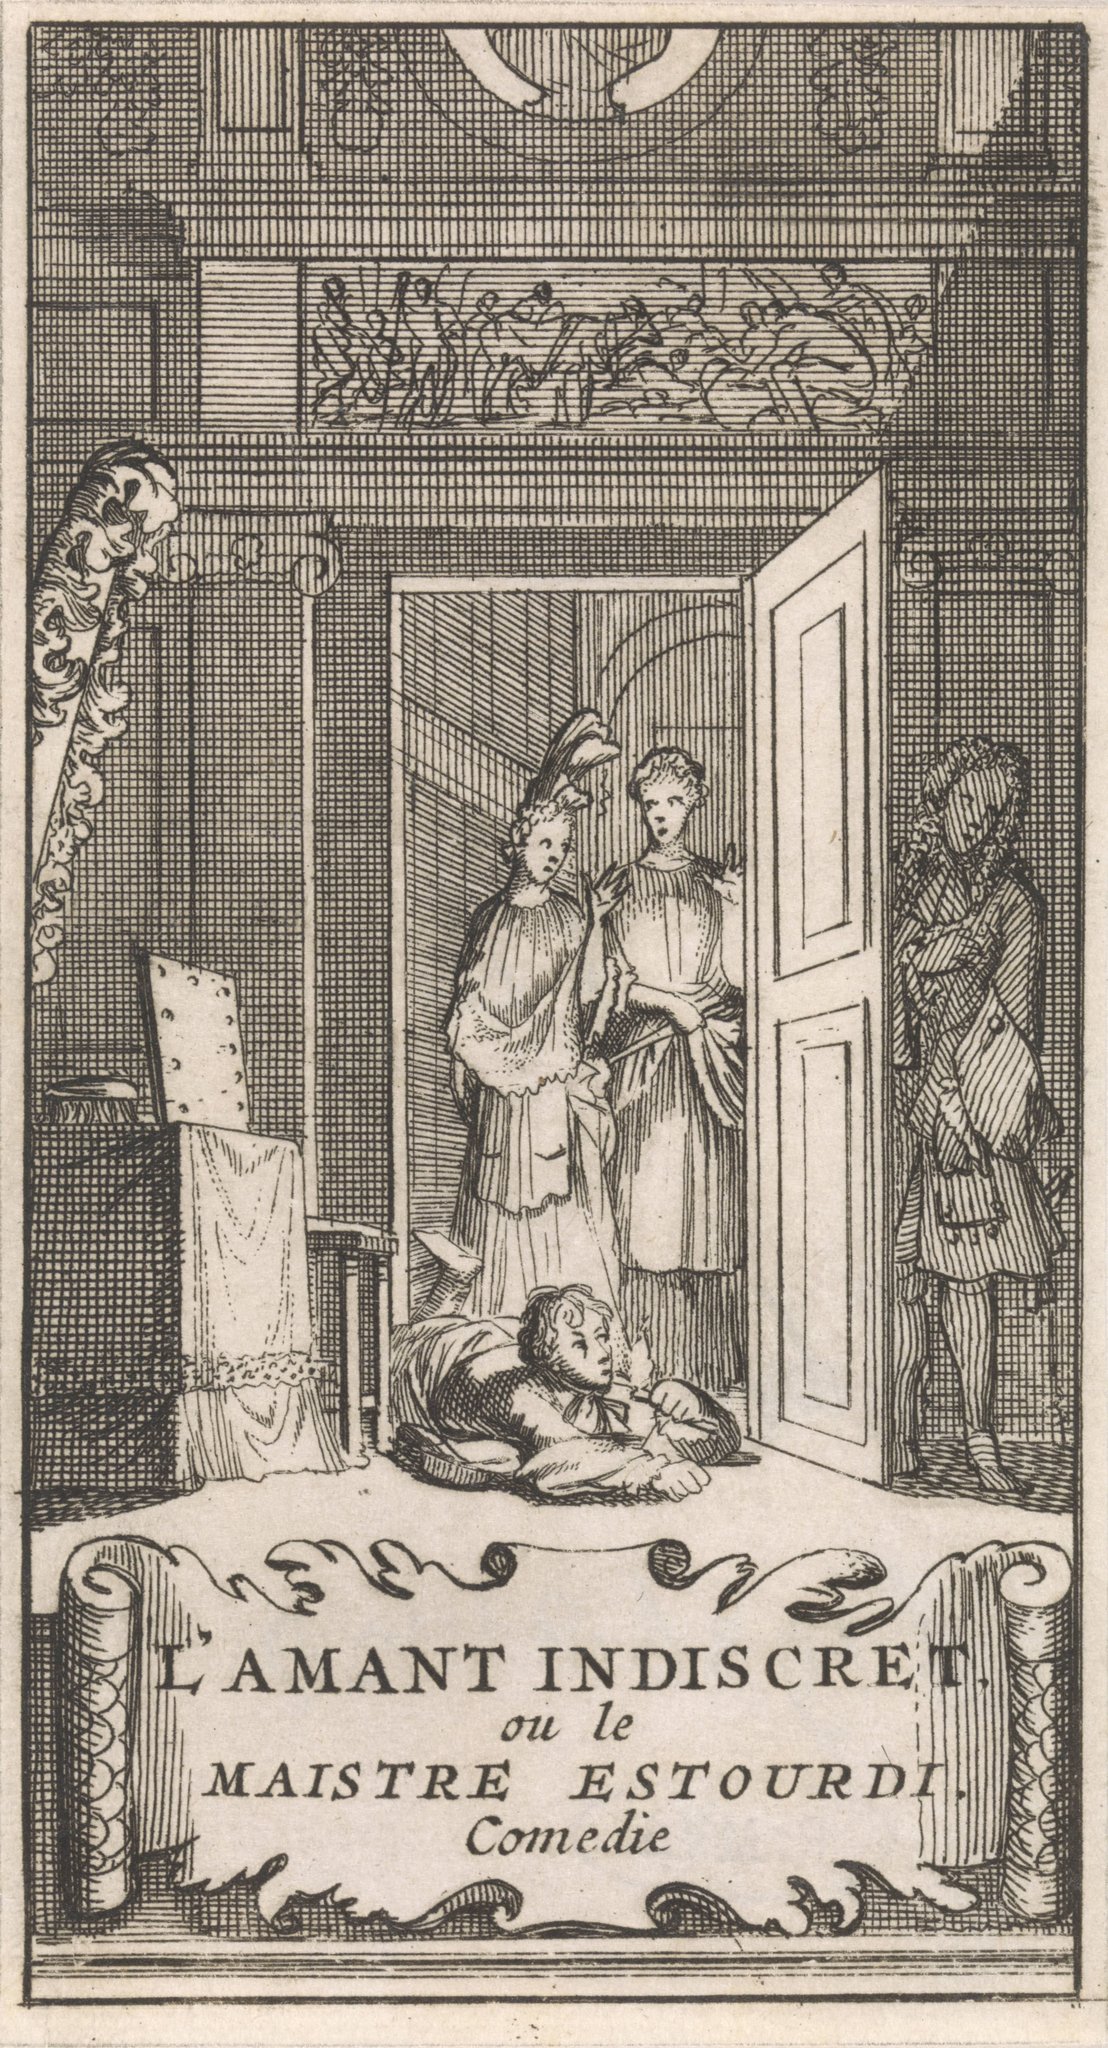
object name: titelblad, titelpagina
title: Titelpagina voor "L'Amant Indiscret, ou le Maistre Estourdi", in: P. Quinault, Le theatre, deel II, 1697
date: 1697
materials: paper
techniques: etching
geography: amsterdam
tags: candle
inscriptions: collector's mark: Lugt 2228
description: Titelpagina voor het toneelstuk "L'Amant Indiscret, ou le Maistre Estourdi" in deel II van: Quinault, Philippe. Le theatre, 2 delen. Amsterdam: Antoine Schelte, 1697.